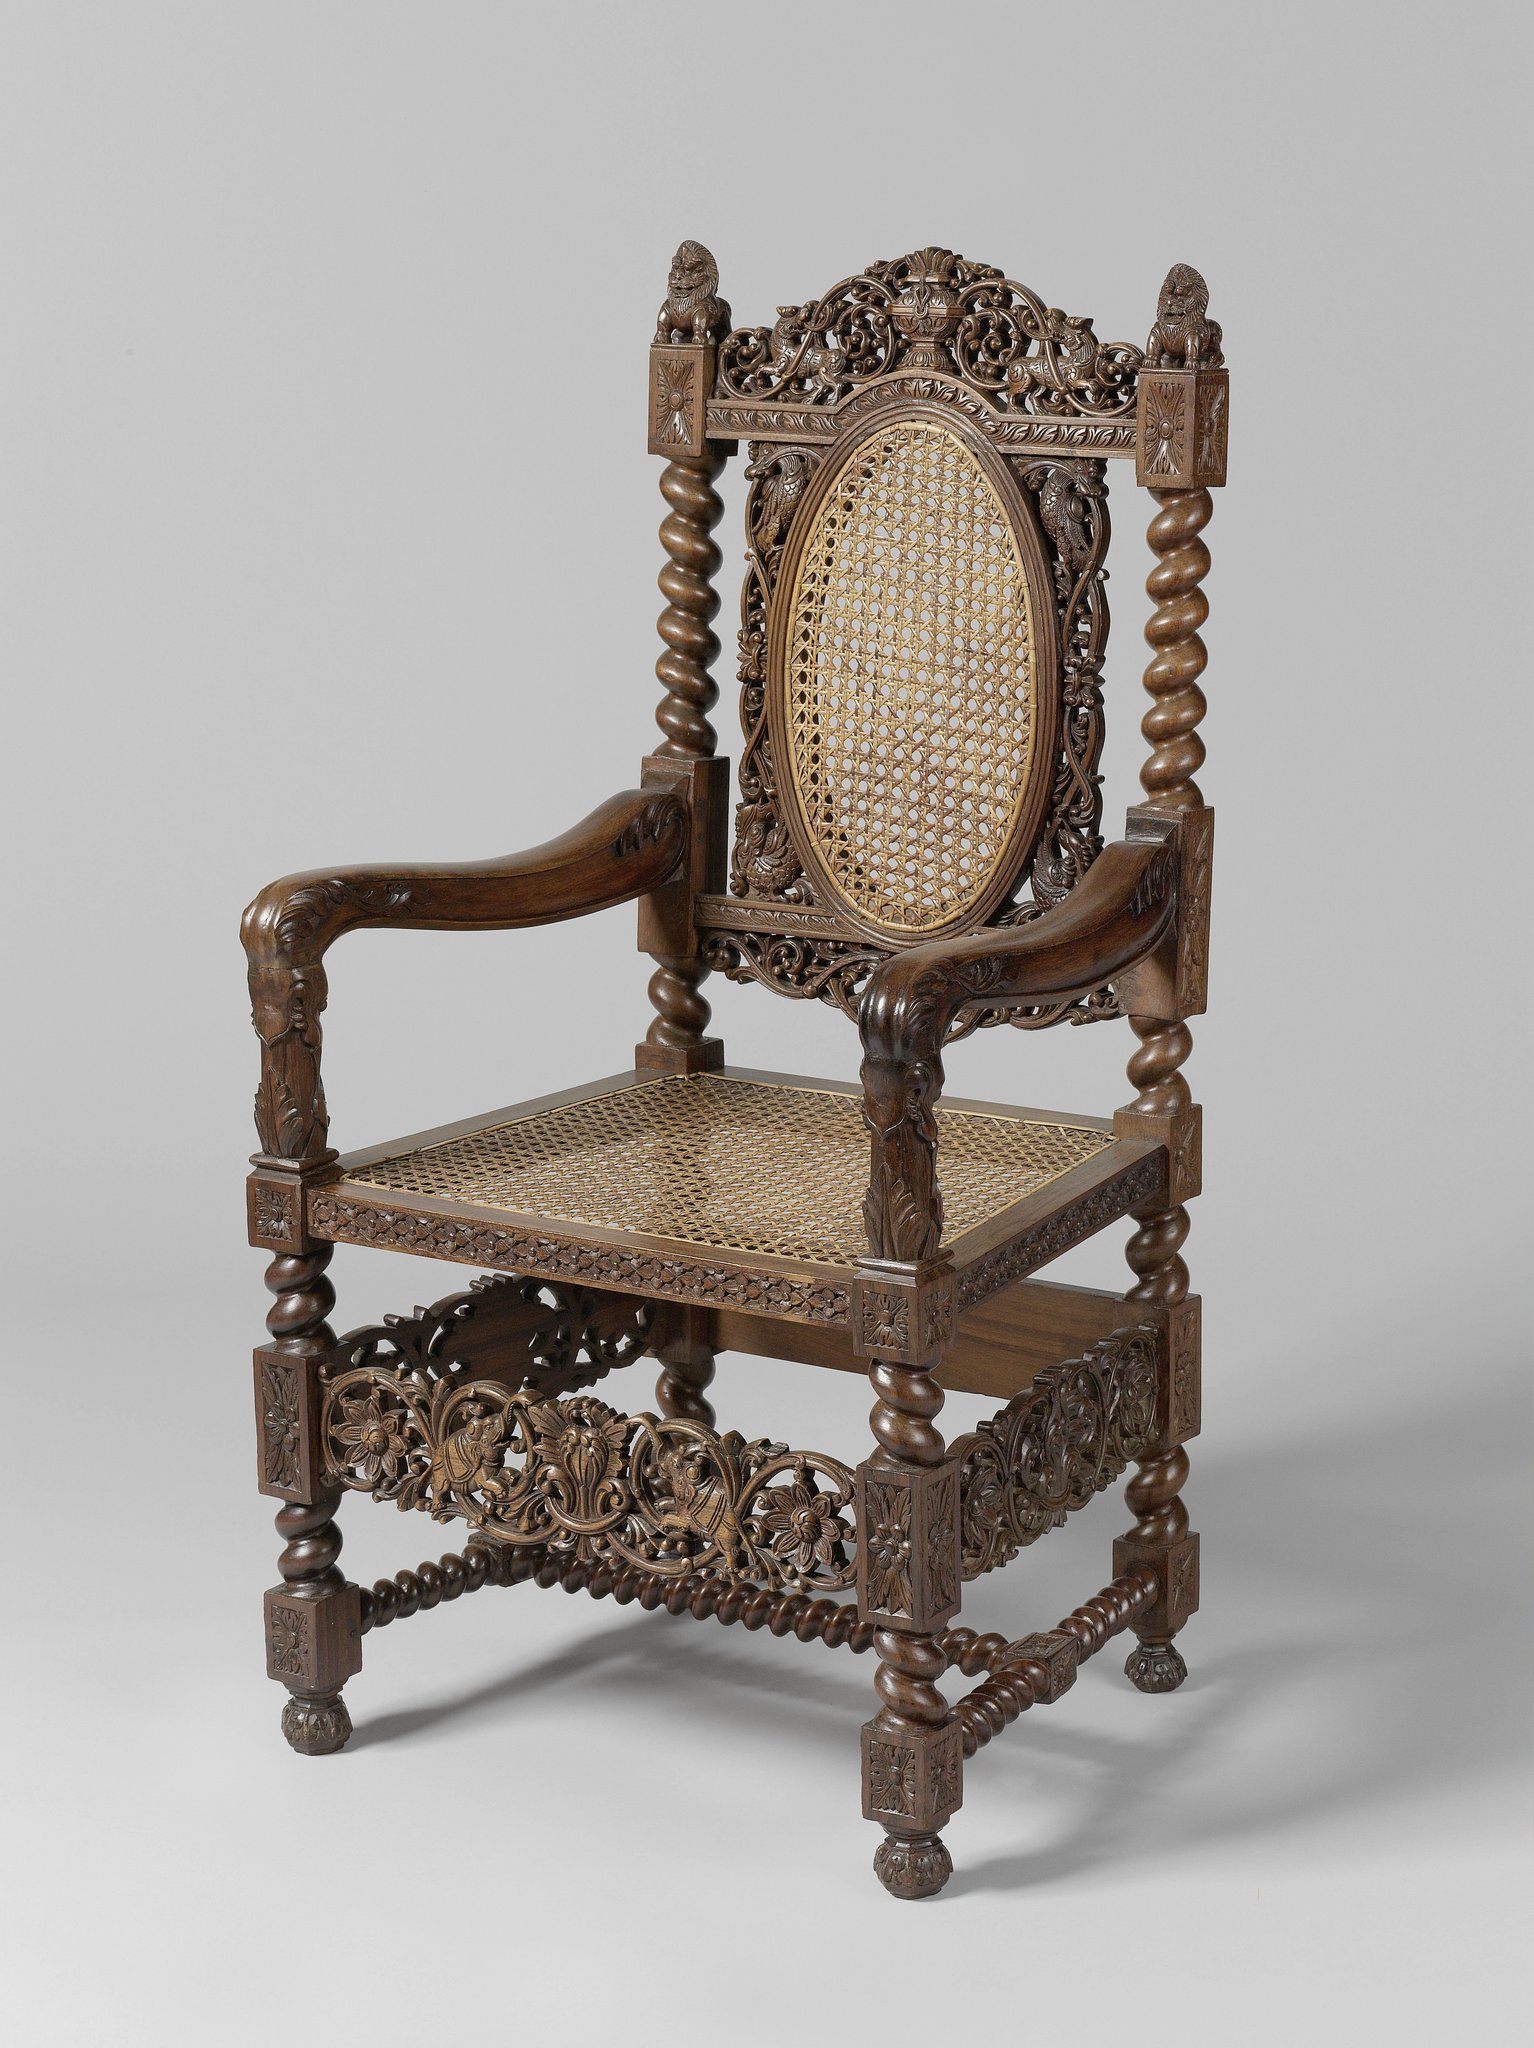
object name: armchair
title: Armstoel met rotan zitting, versierd met rozetten en getordeerde delen, op boogvormige bovenregel een opengewerkte bekroning, armleggers eindigen in ofifantachtige koppen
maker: Anonymous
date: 1700-1725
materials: wood, rattan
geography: indonesia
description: Armchair. Ironwood, cane. Indonesia or Ceylon, c. 1700 - 1725.